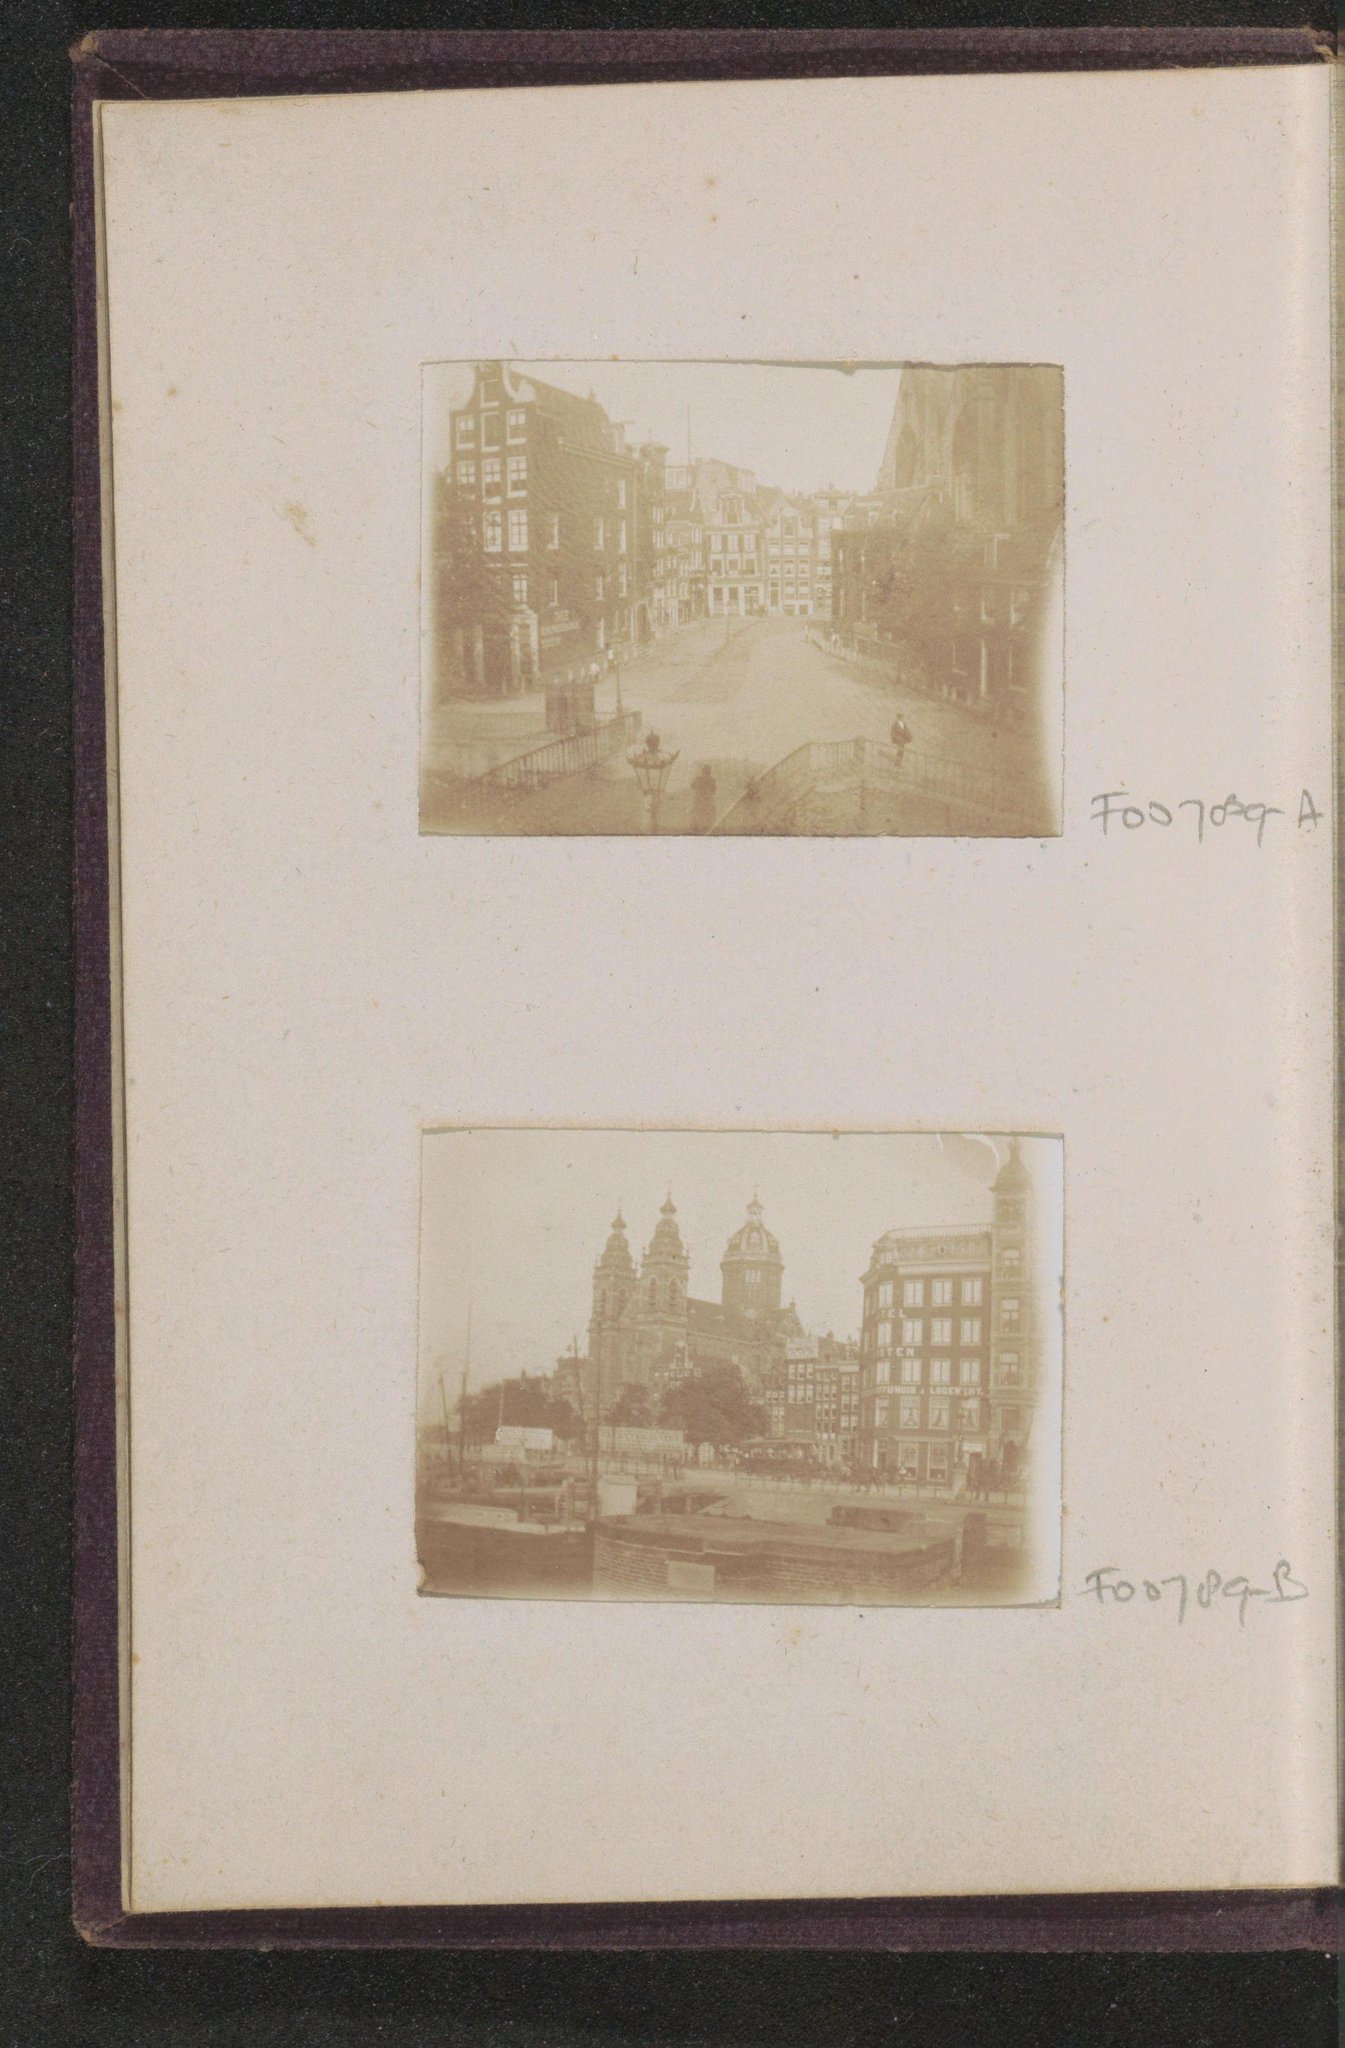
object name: photograph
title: Gezicht op het Oudekerksplein te Amsterdam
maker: Anonymous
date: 1880-1900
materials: paper, photographic support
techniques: collodion silver print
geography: amsterdam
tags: street (+ city(-scape) with figures, staffage)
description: Gezicht op het Oudekerskplein te Amsterdam. Rechts de Oude Kerk. Onderdeel van Fotoalbum met 35 foto's van Amsterdam, personen en dieren.